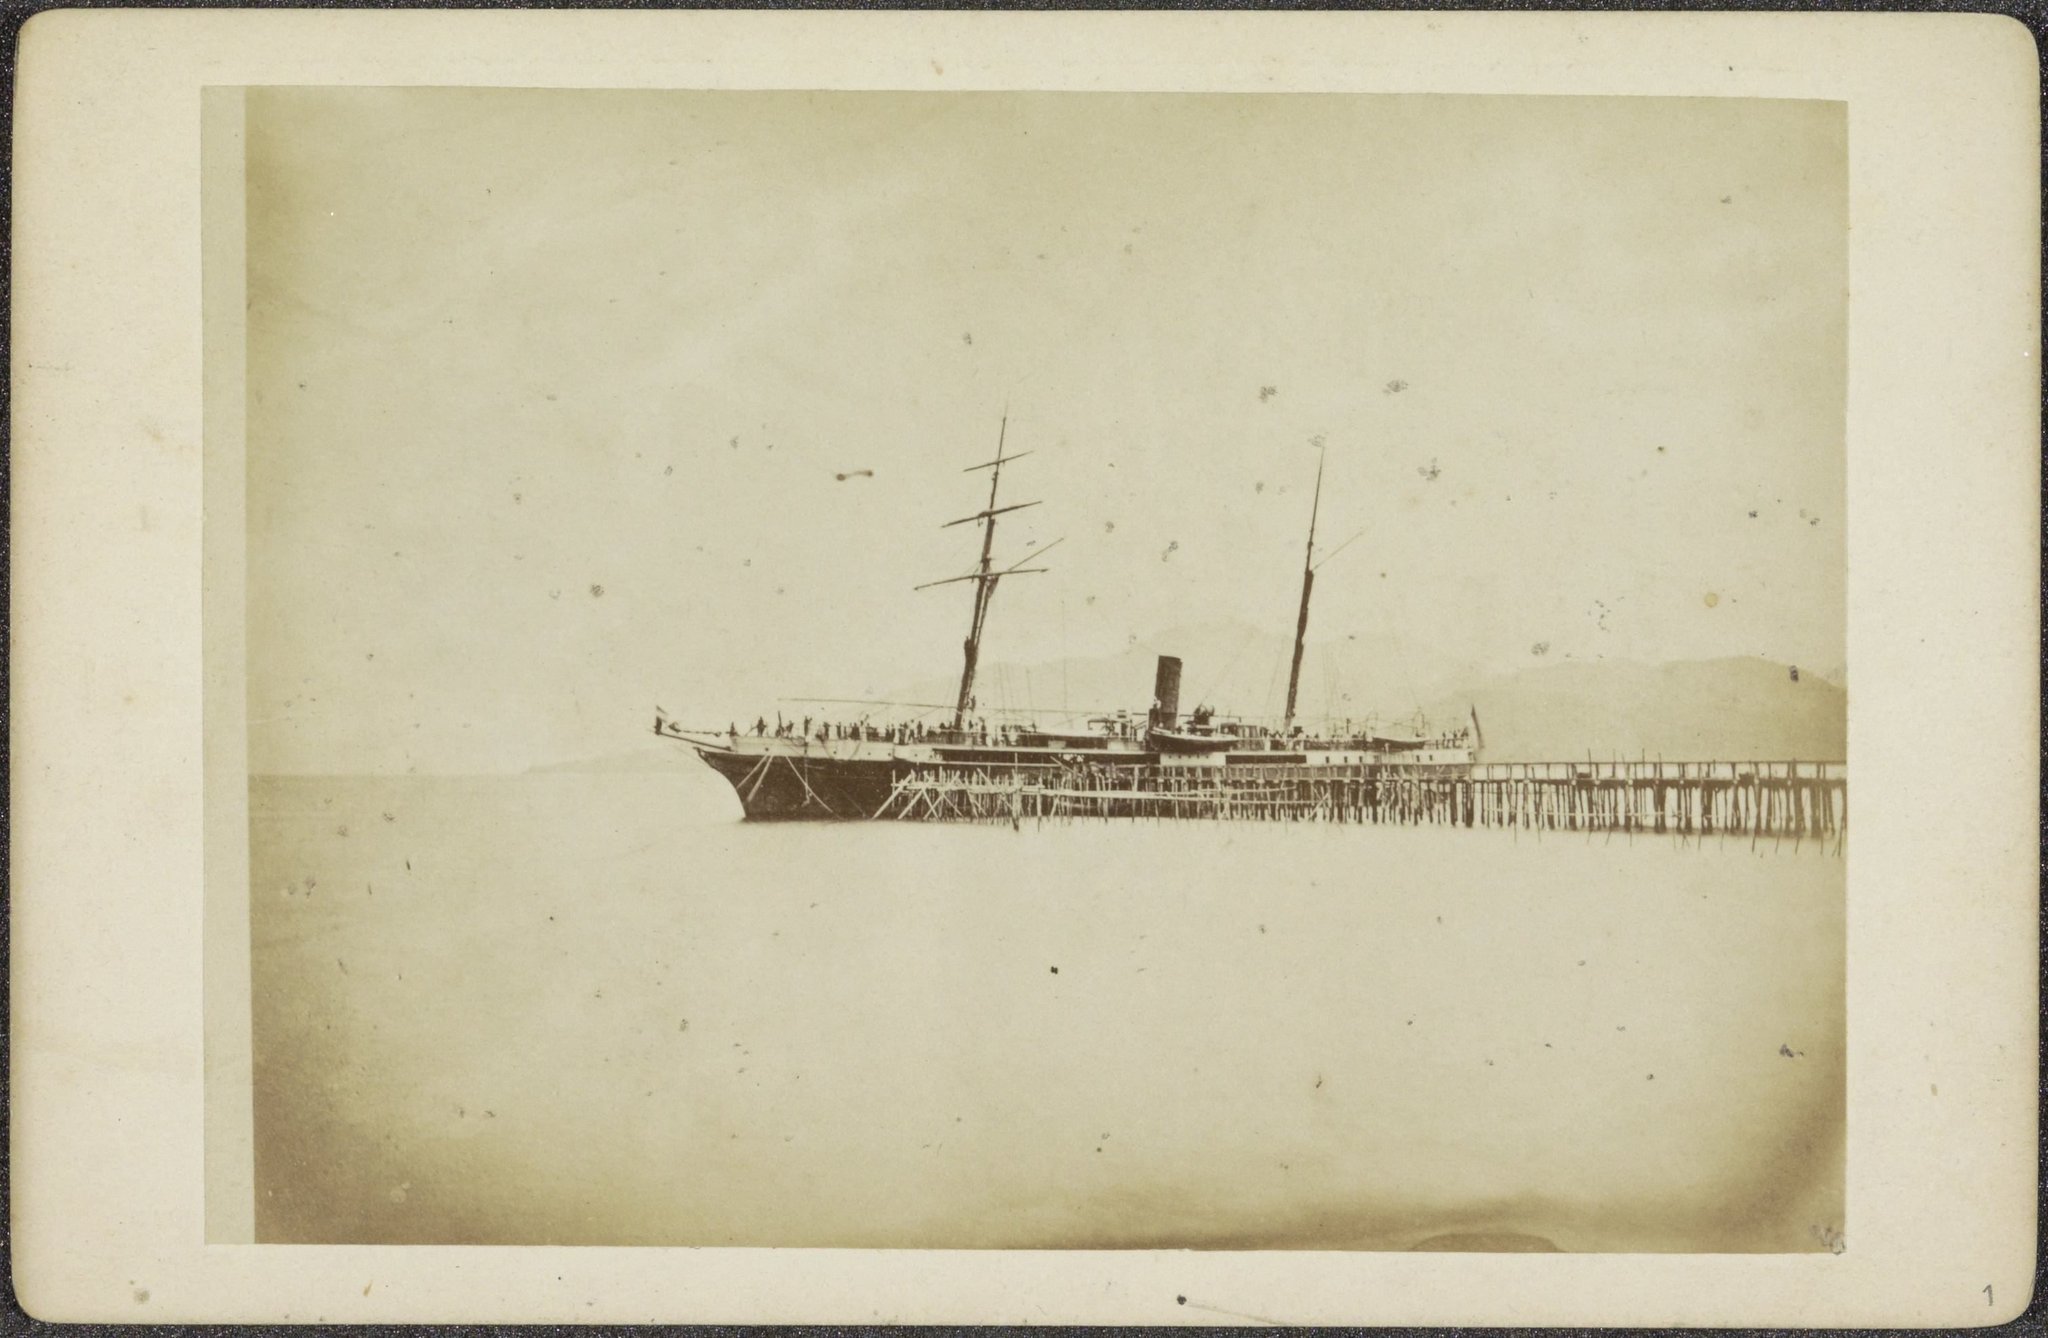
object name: cabinet photograph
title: Mailboot aan een steiger in Ternate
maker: Anonymous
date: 1860-1900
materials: cardboard, paper, photographic support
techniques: albumen print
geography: ternate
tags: pier, quay, wharf, steamship, motorship, dutch east indies, the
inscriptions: inscription: ‘Molukken. De mailboot aan den steiger ter Ternate.’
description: Onderdeel van Album met foto's van de Molukken.